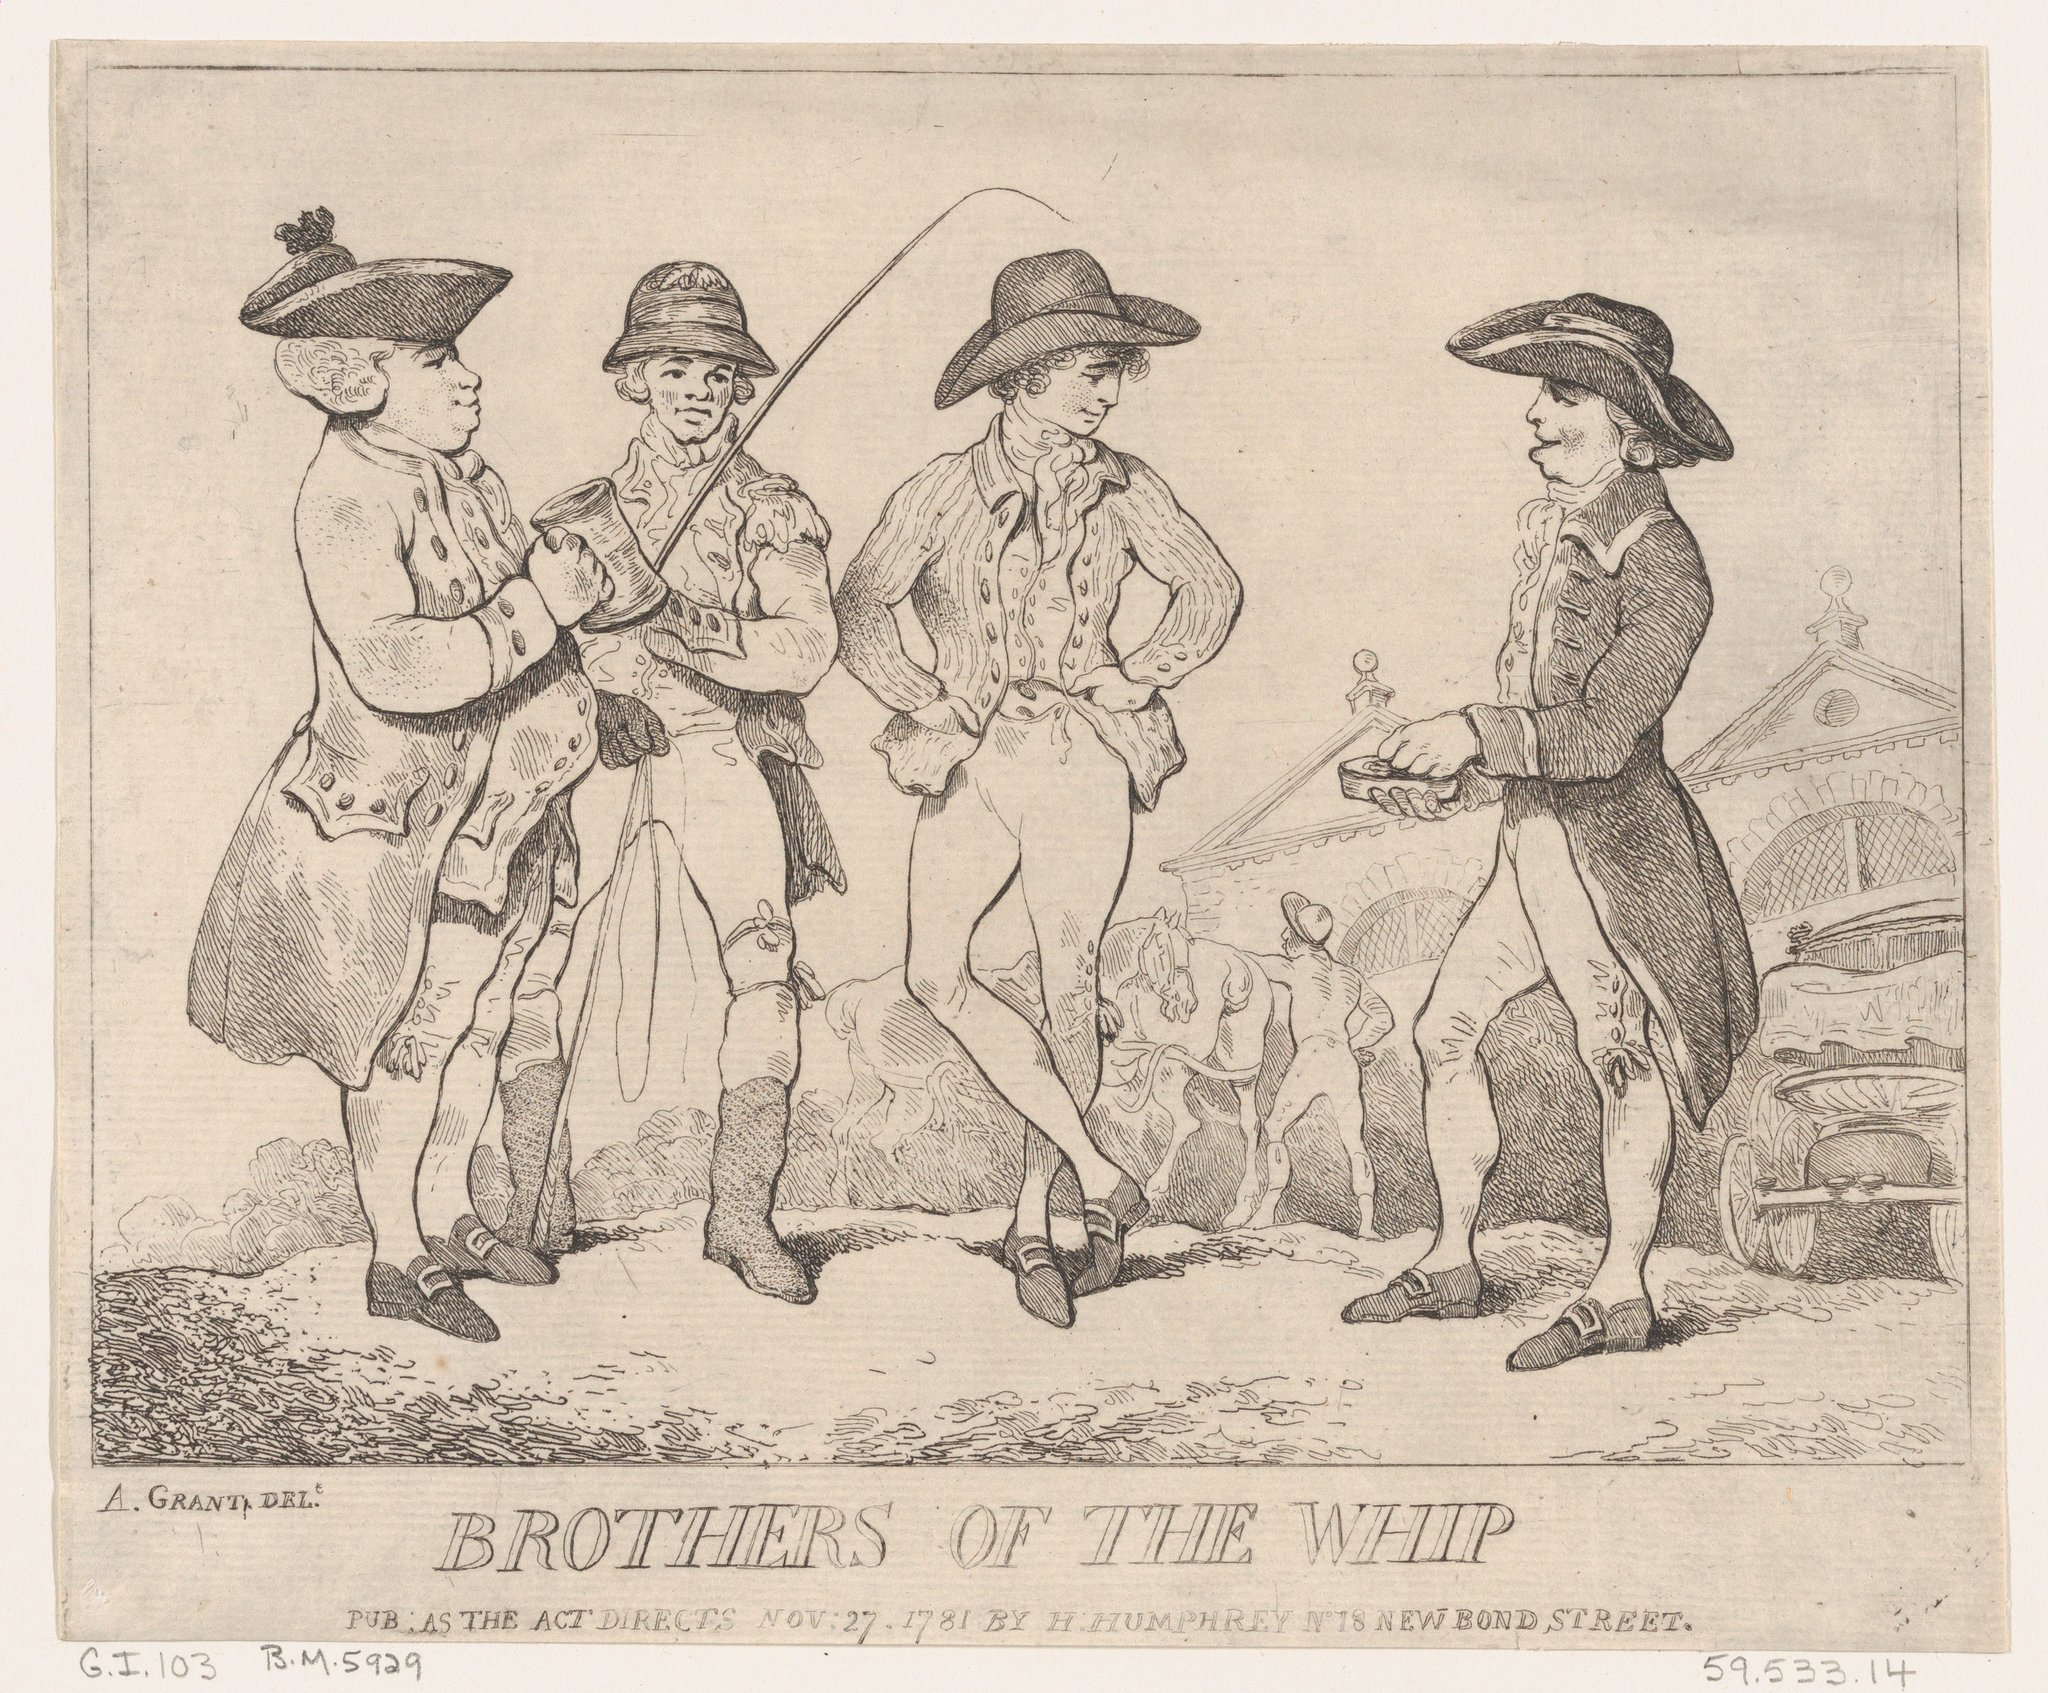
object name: print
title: Brothers of the Whip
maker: thomas rowlandson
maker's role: artist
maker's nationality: british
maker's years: 1757-1827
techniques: etching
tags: satire,men